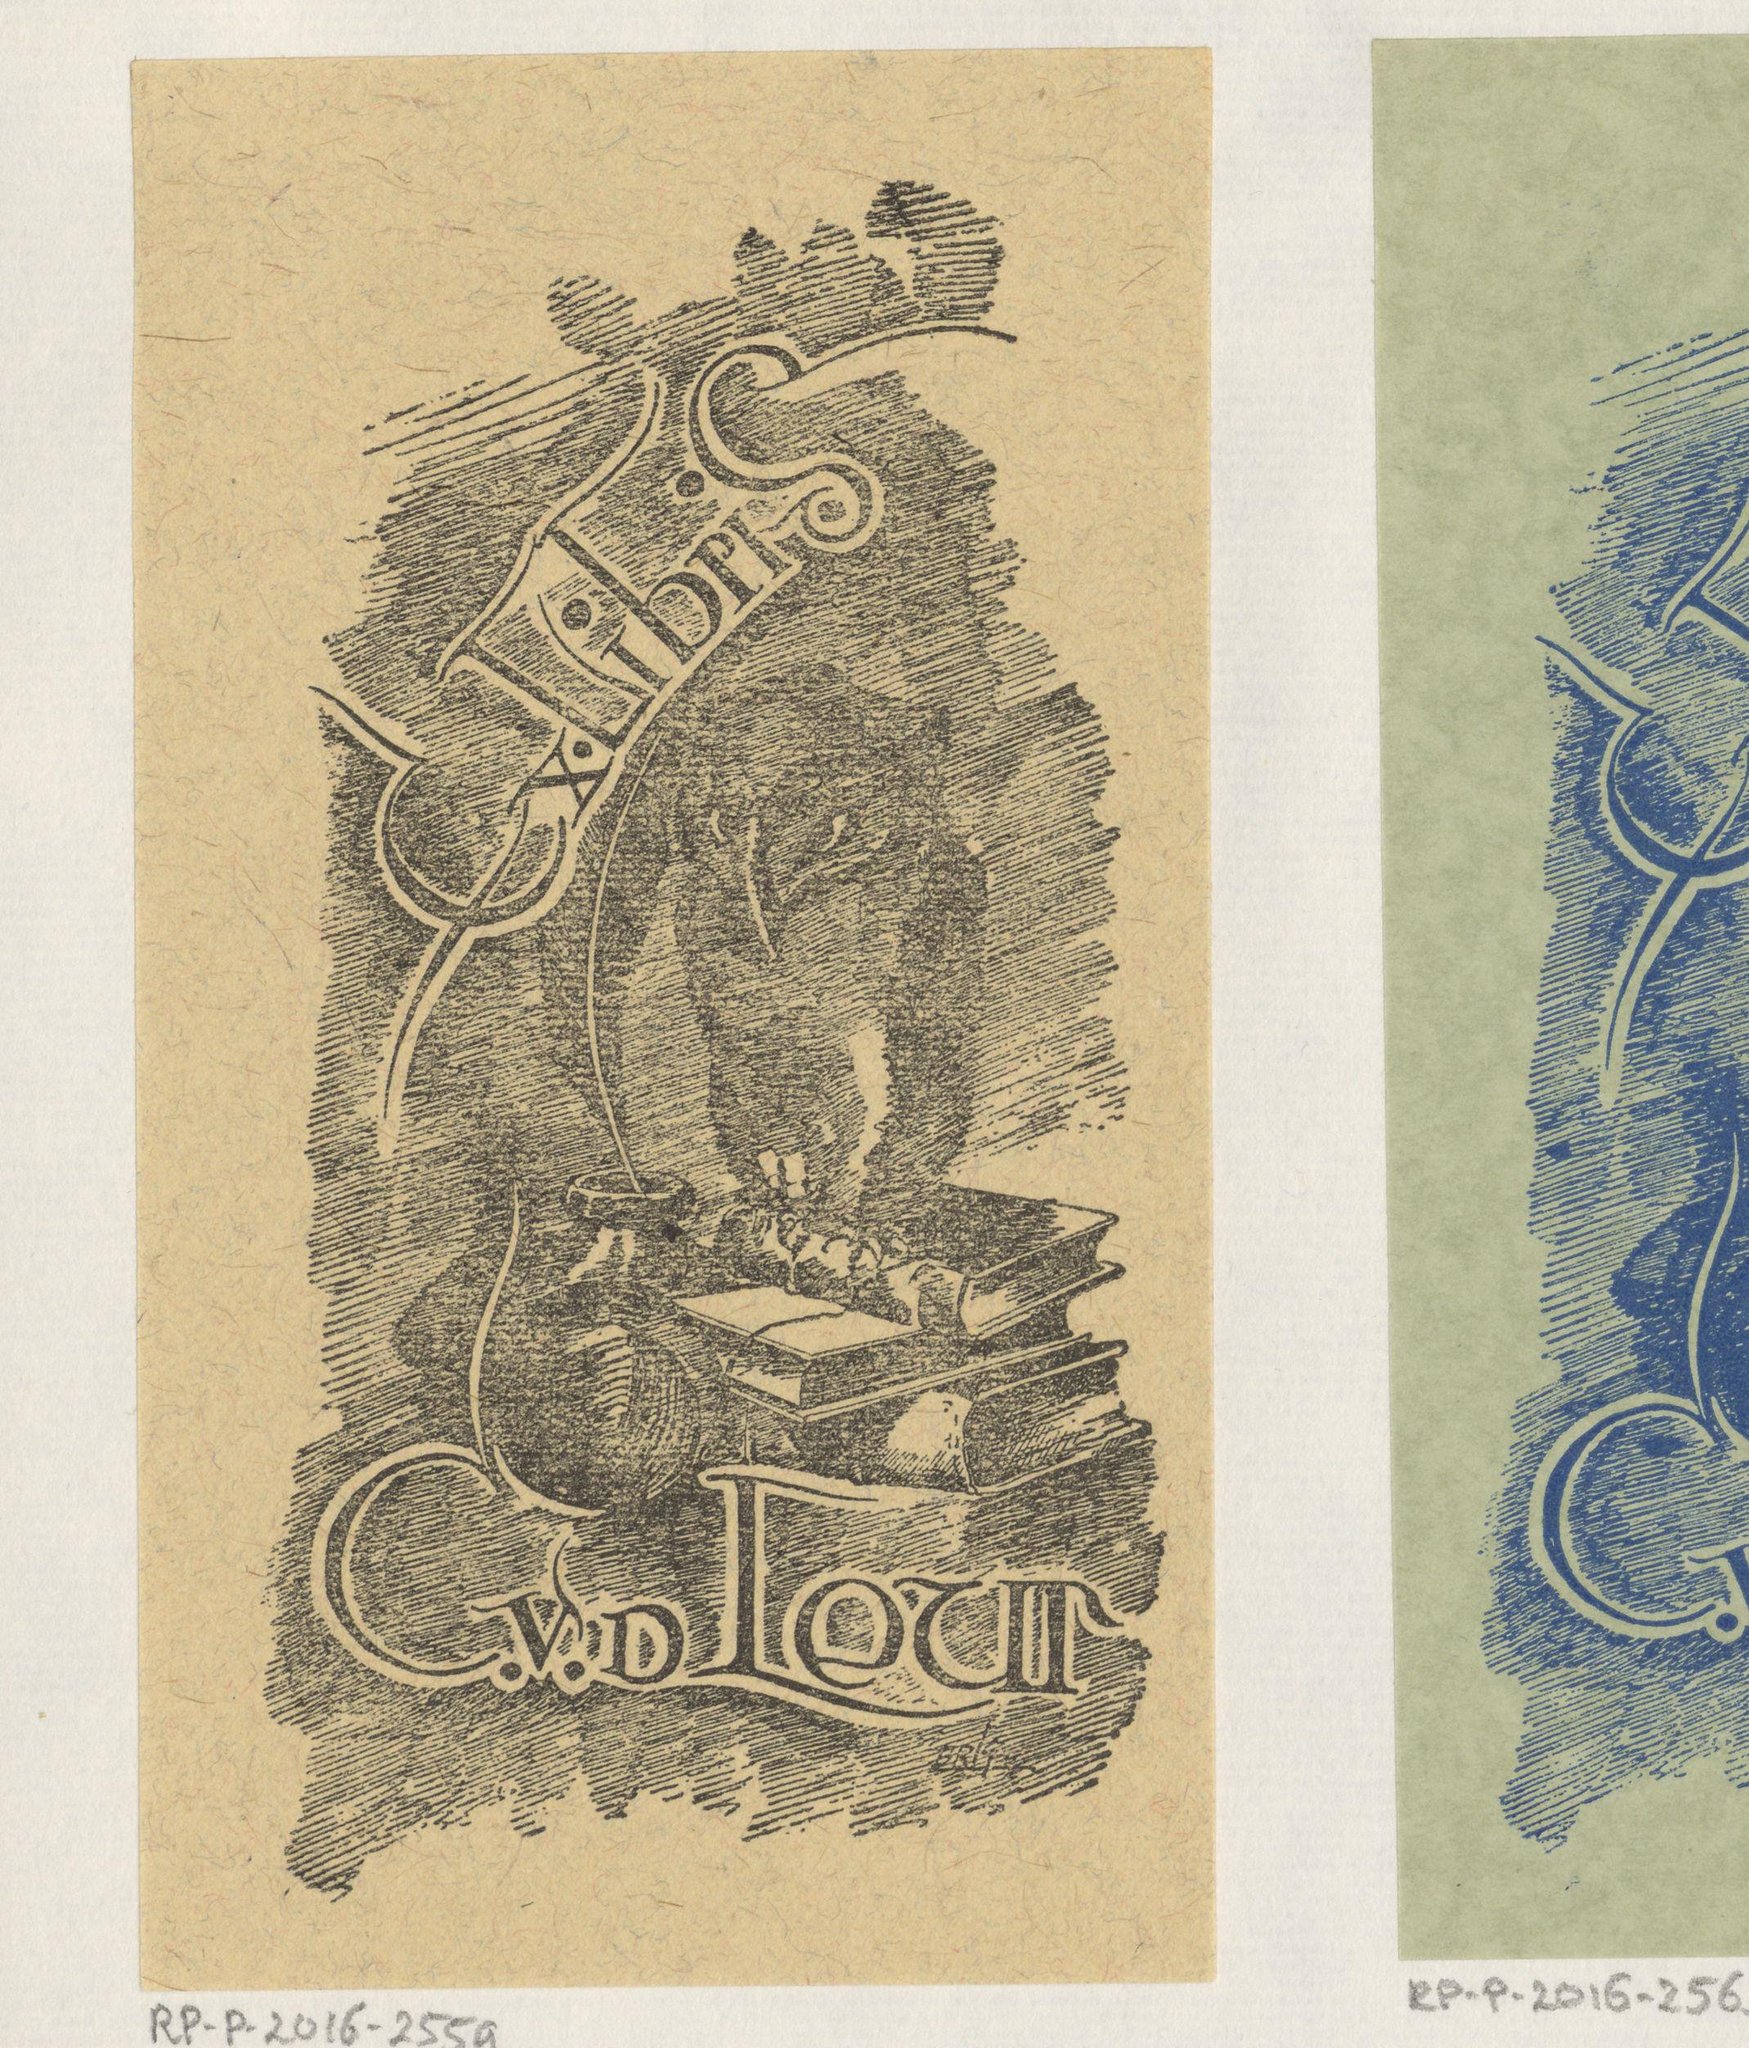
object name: bookplate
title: Ex libris van C. v.d. Leur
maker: jos van de leur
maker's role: print maker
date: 1948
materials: paper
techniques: printing block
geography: netherlands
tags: quill, ink-well, owls